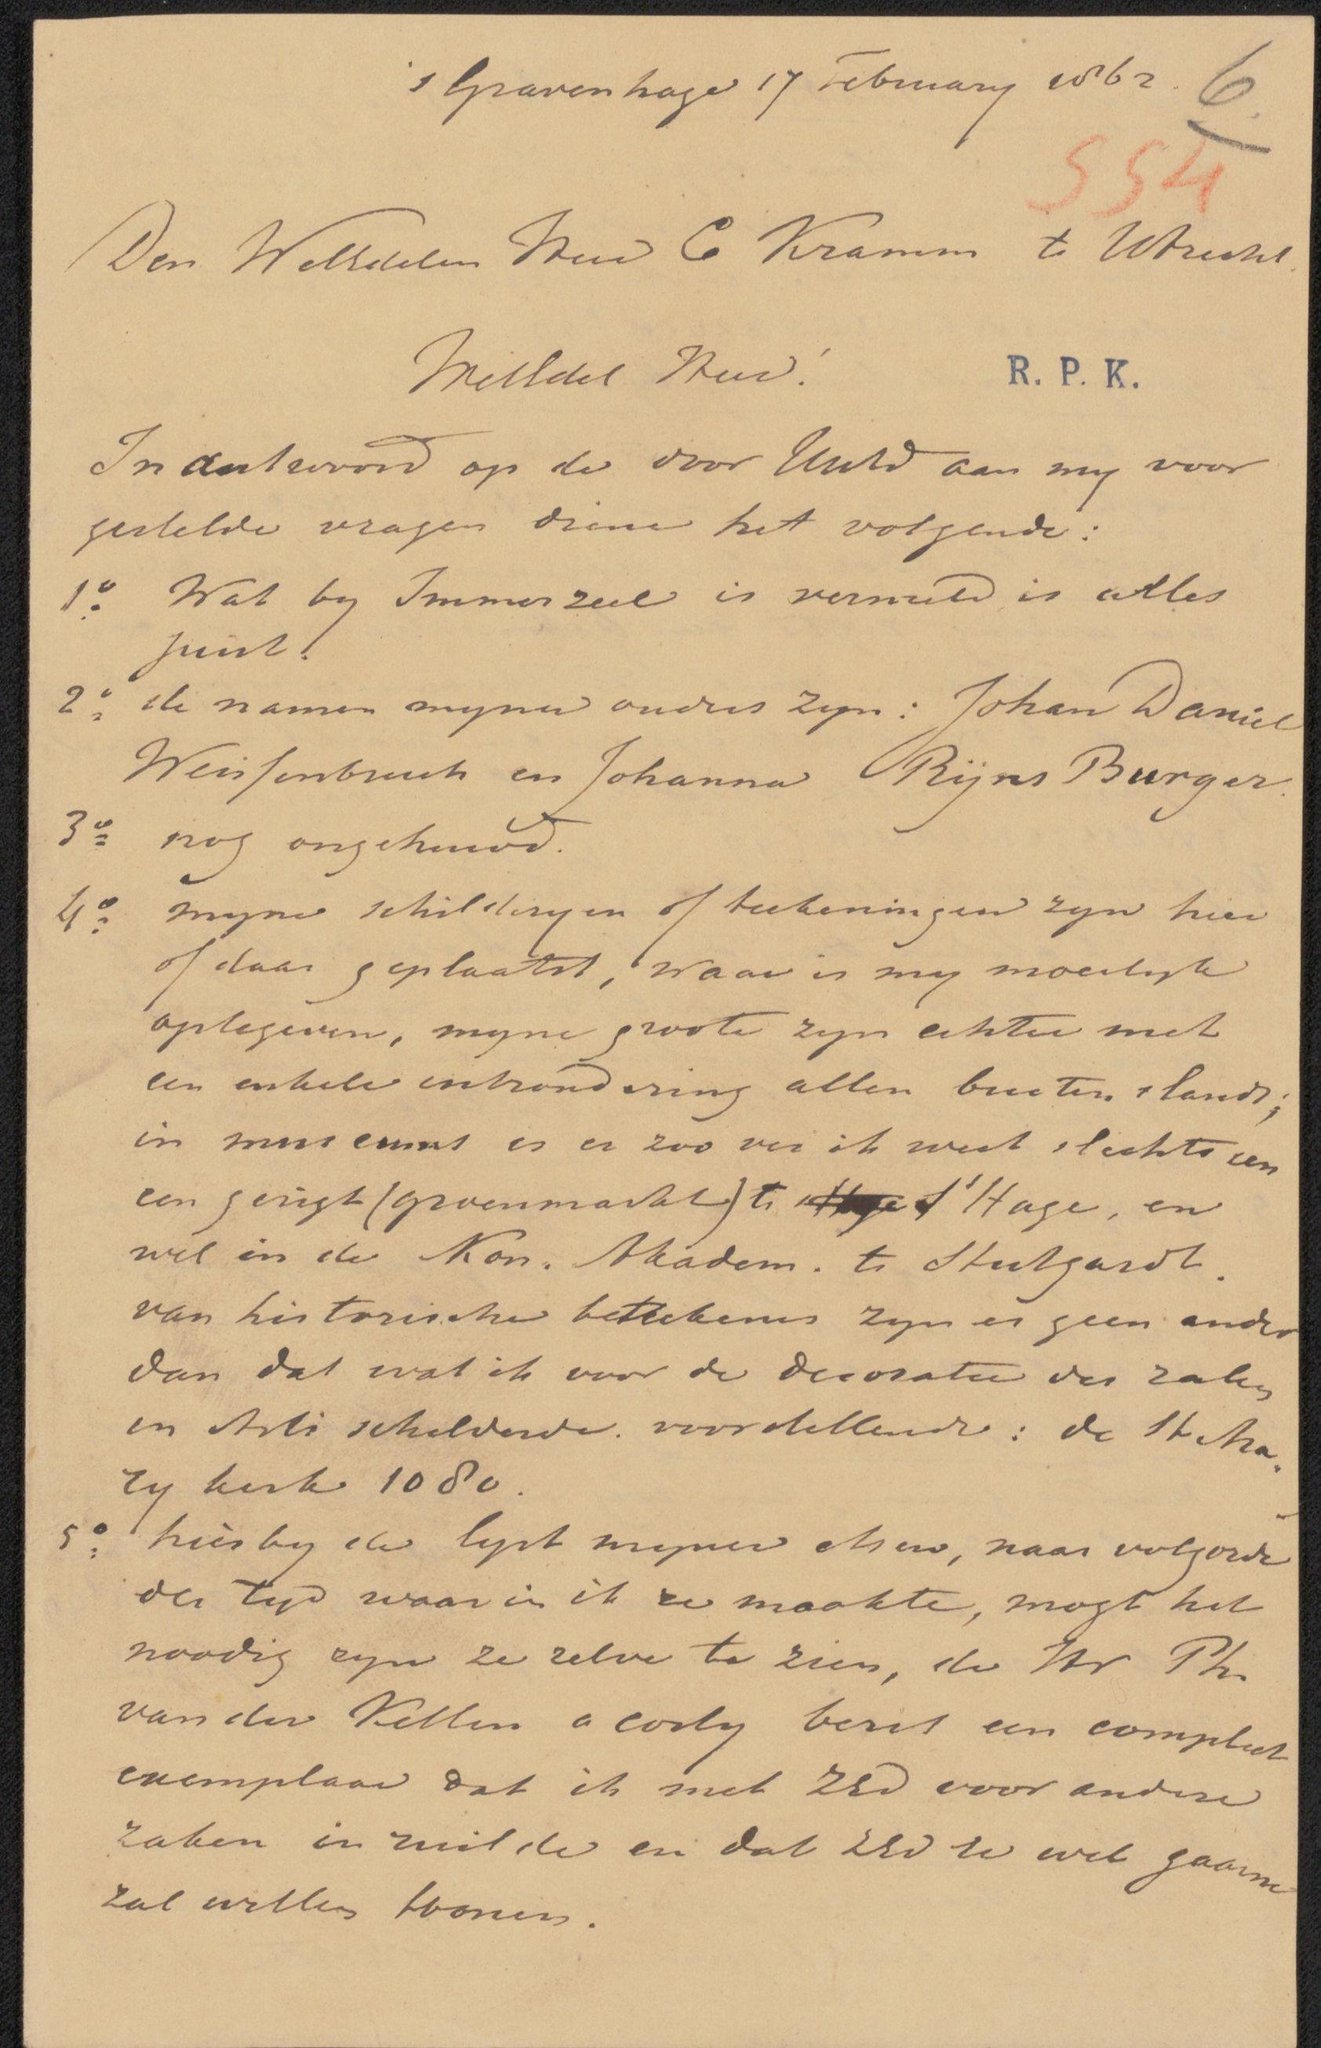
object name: letter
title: Brief aan Christiaan Kramm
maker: jan weissenbruch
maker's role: painter, print maker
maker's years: 1822-1880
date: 1862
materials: ink, paper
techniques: pen, writing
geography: the hague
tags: the hague, painter, lambertus hardenberg (1822-1900), utrecht, print maker, draughtsman, christiaan kramm, drawing, the graphic arts, education, tuition of the artist (in general), painting (including book-illumination, miniature-painting), historical persons (portraits and scenes from the life)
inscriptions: collector's mark: Lugt 2233, collector's mark: Lugt 2228